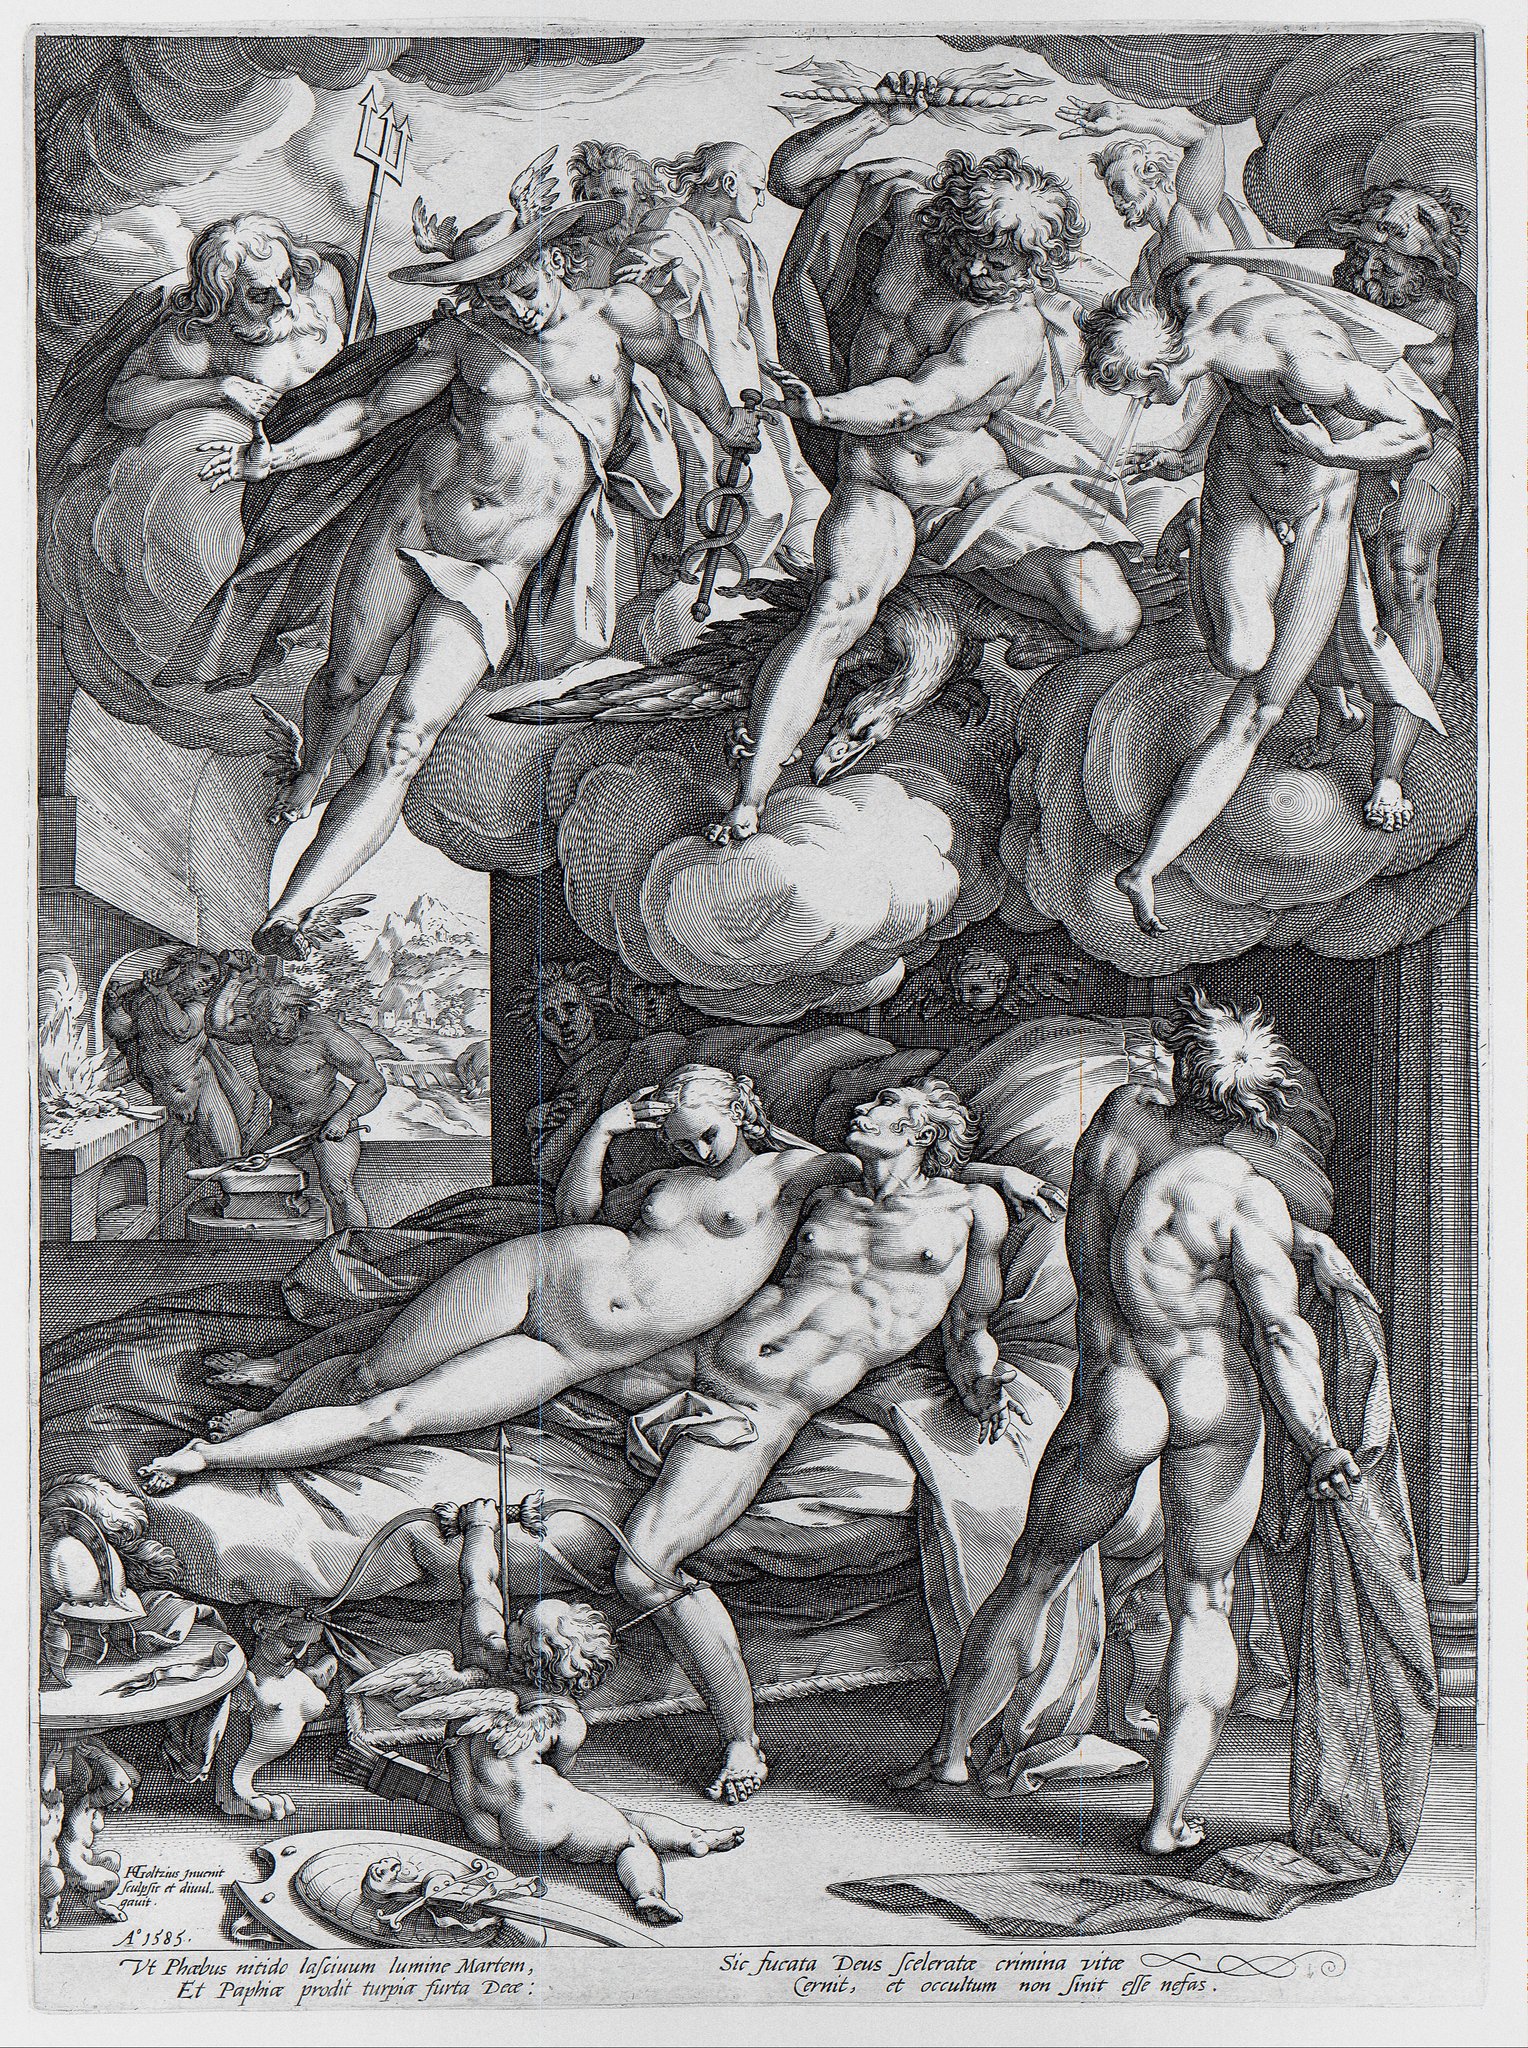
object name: print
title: Venus en Mars betrapt door Vulcanus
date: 1585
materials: paper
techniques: engraving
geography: haarlem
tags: mars and venus surprised by vulcan; he catches them in a net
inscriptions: date: ‘Ao 1585.’, collector's mark: Lugt 2228a, signature: ‘HGoltzius jnuenit/sculpsit et diuul./gauit.’, caption: ‘Vt Phoebus ...sinit esse nefas.’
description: Vulcanus staat klaar om zijn overspelige vrouw Venus en haar minnaar Mars te vangen in een zelfgesmeed net. Een schare van mannelijke goden kijkt vanuit de hemel toe. Links op de achtergrond is te zien hoe Vulcanus zijn net vervaardigt. Onder de voorstelling vier regels Latijn.